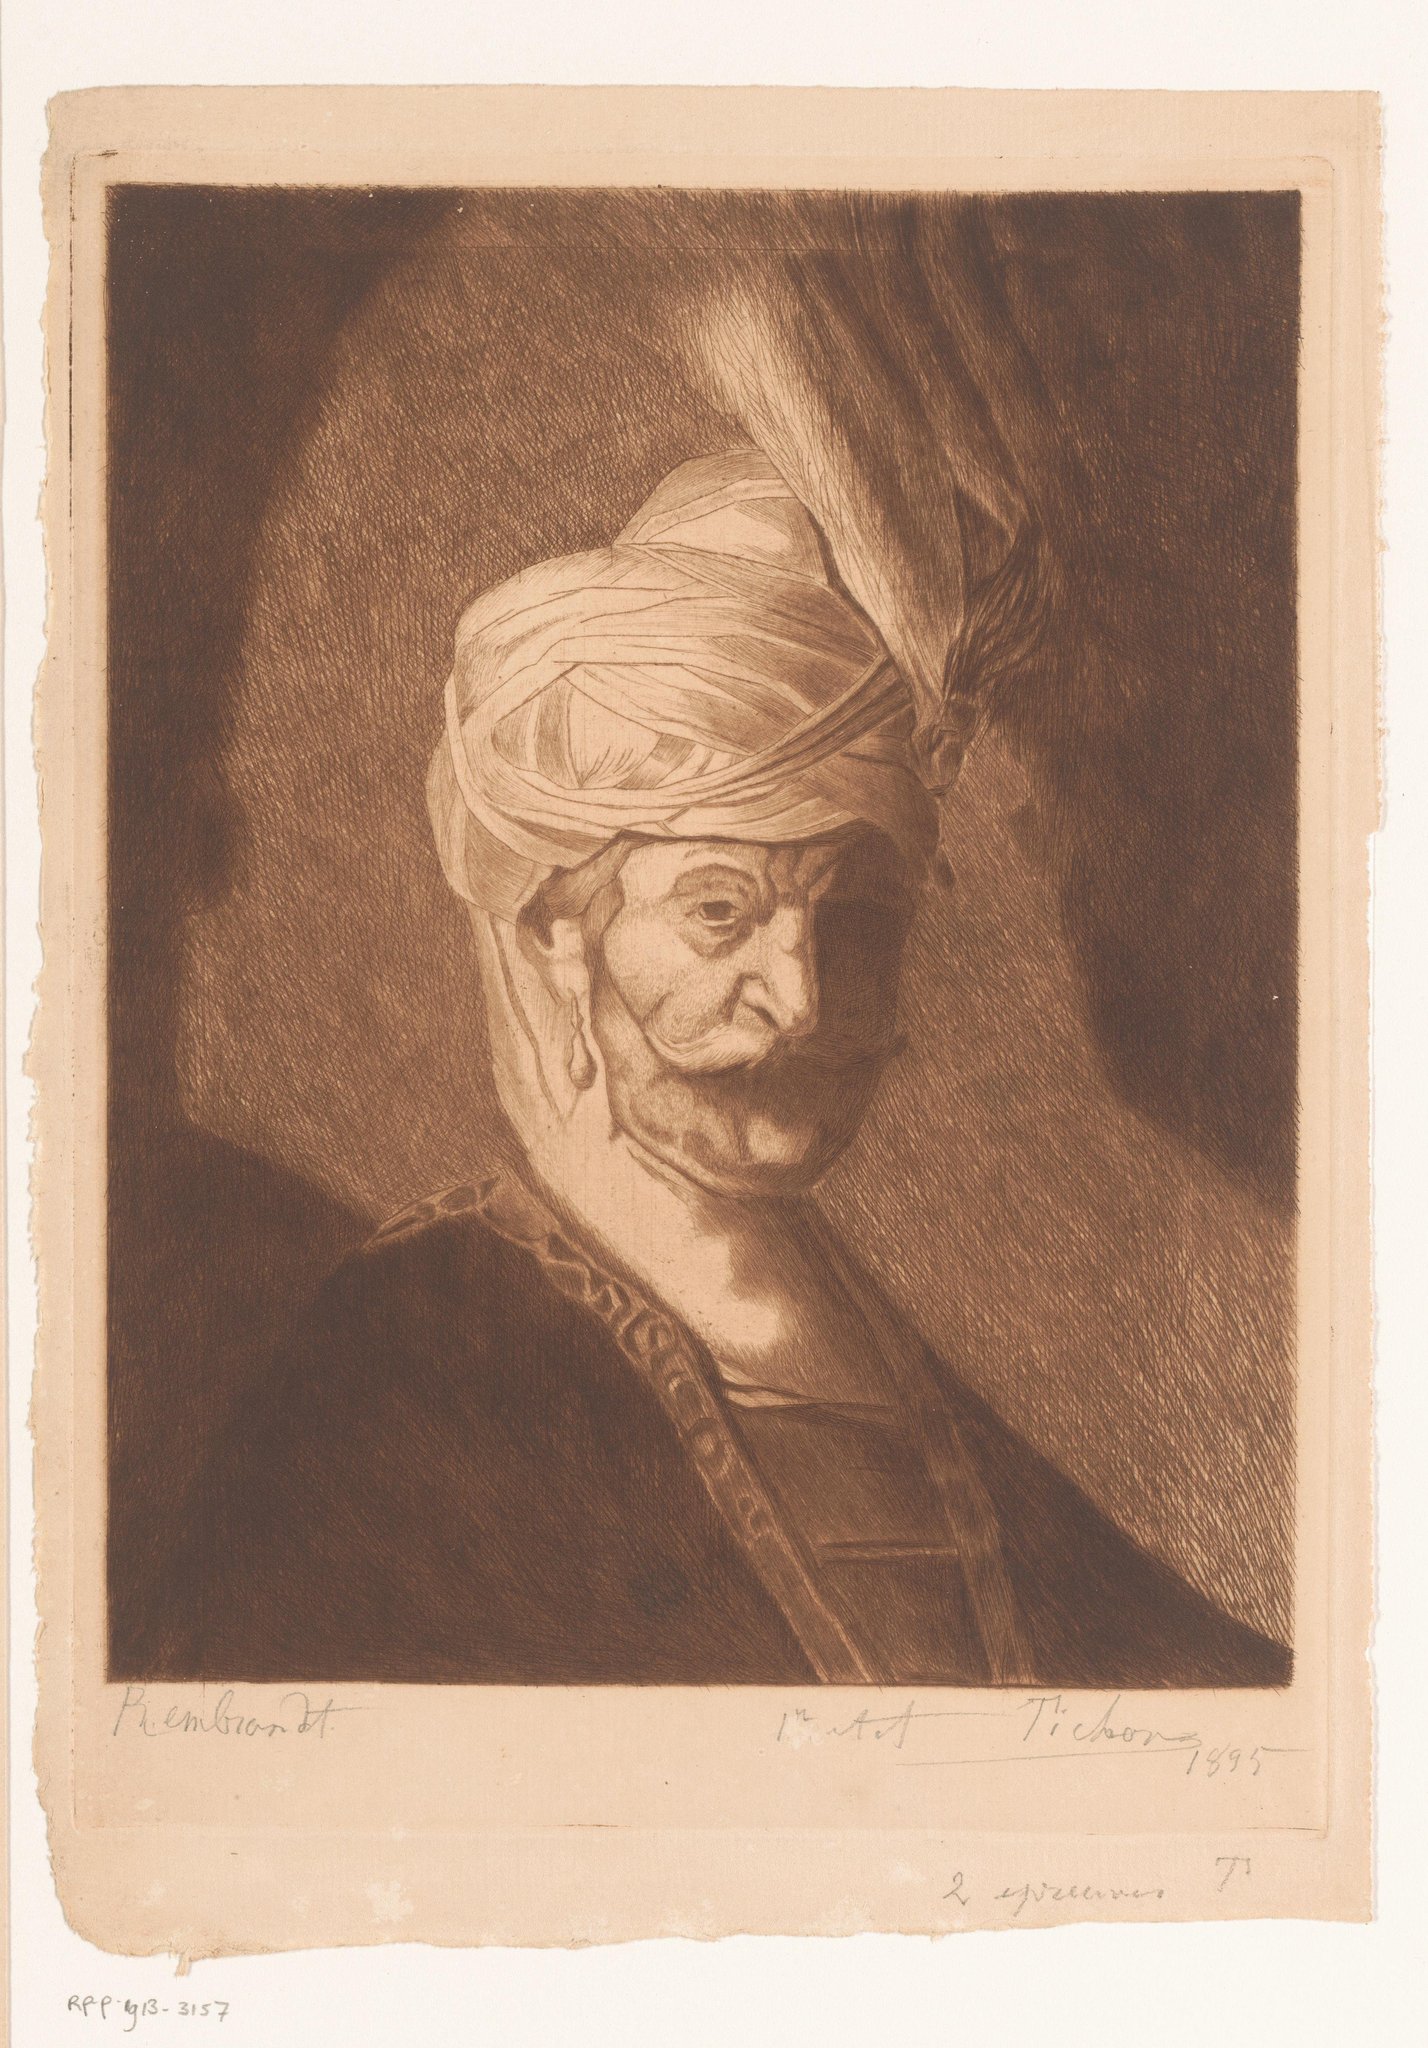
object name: print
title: Kop van een oosterling naar Rembrandt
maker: charles tichon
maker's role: draughtsman, painter, print maker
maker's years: 1865-1924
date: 1895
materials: paper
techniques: etching, intaglio, retroussage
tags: moustache, adult man, head-gear: turban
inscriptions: inscription: ‘Rembrandt; 1e etat; 1895; 2 epreuves T’, collector's mark: Lugt 2228